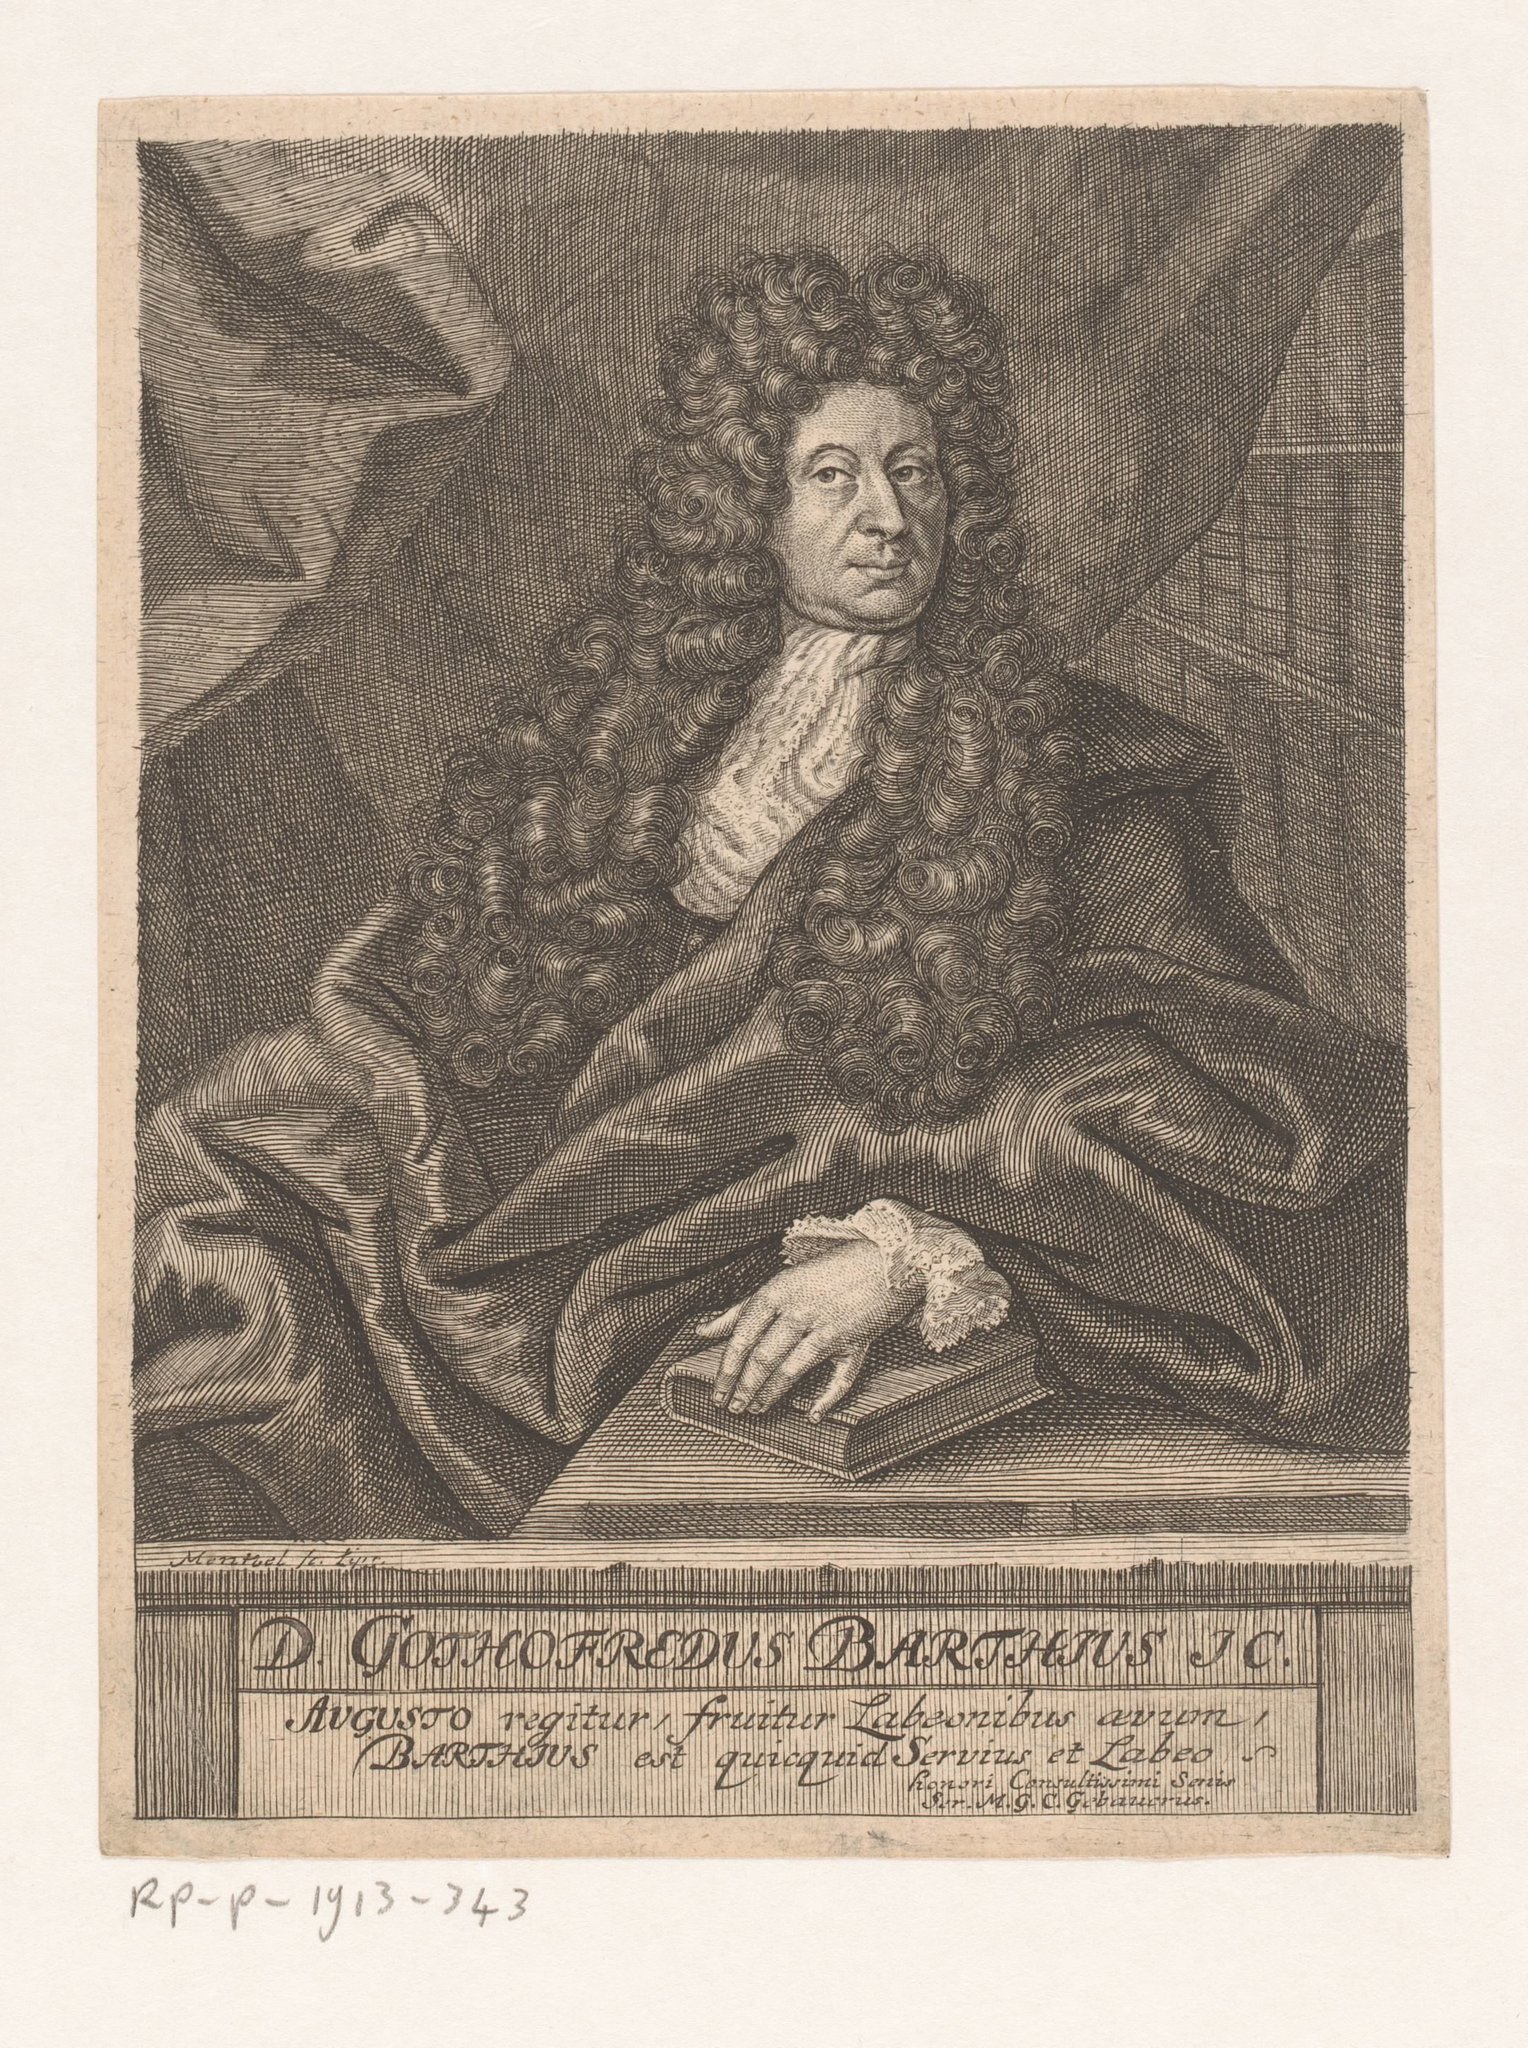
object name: print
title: Portret van Gottfried Barth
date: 1720-1743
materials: paper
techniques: engraving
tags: bookshelves, historical persons, book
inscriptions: collector's mark: Lugt 2228